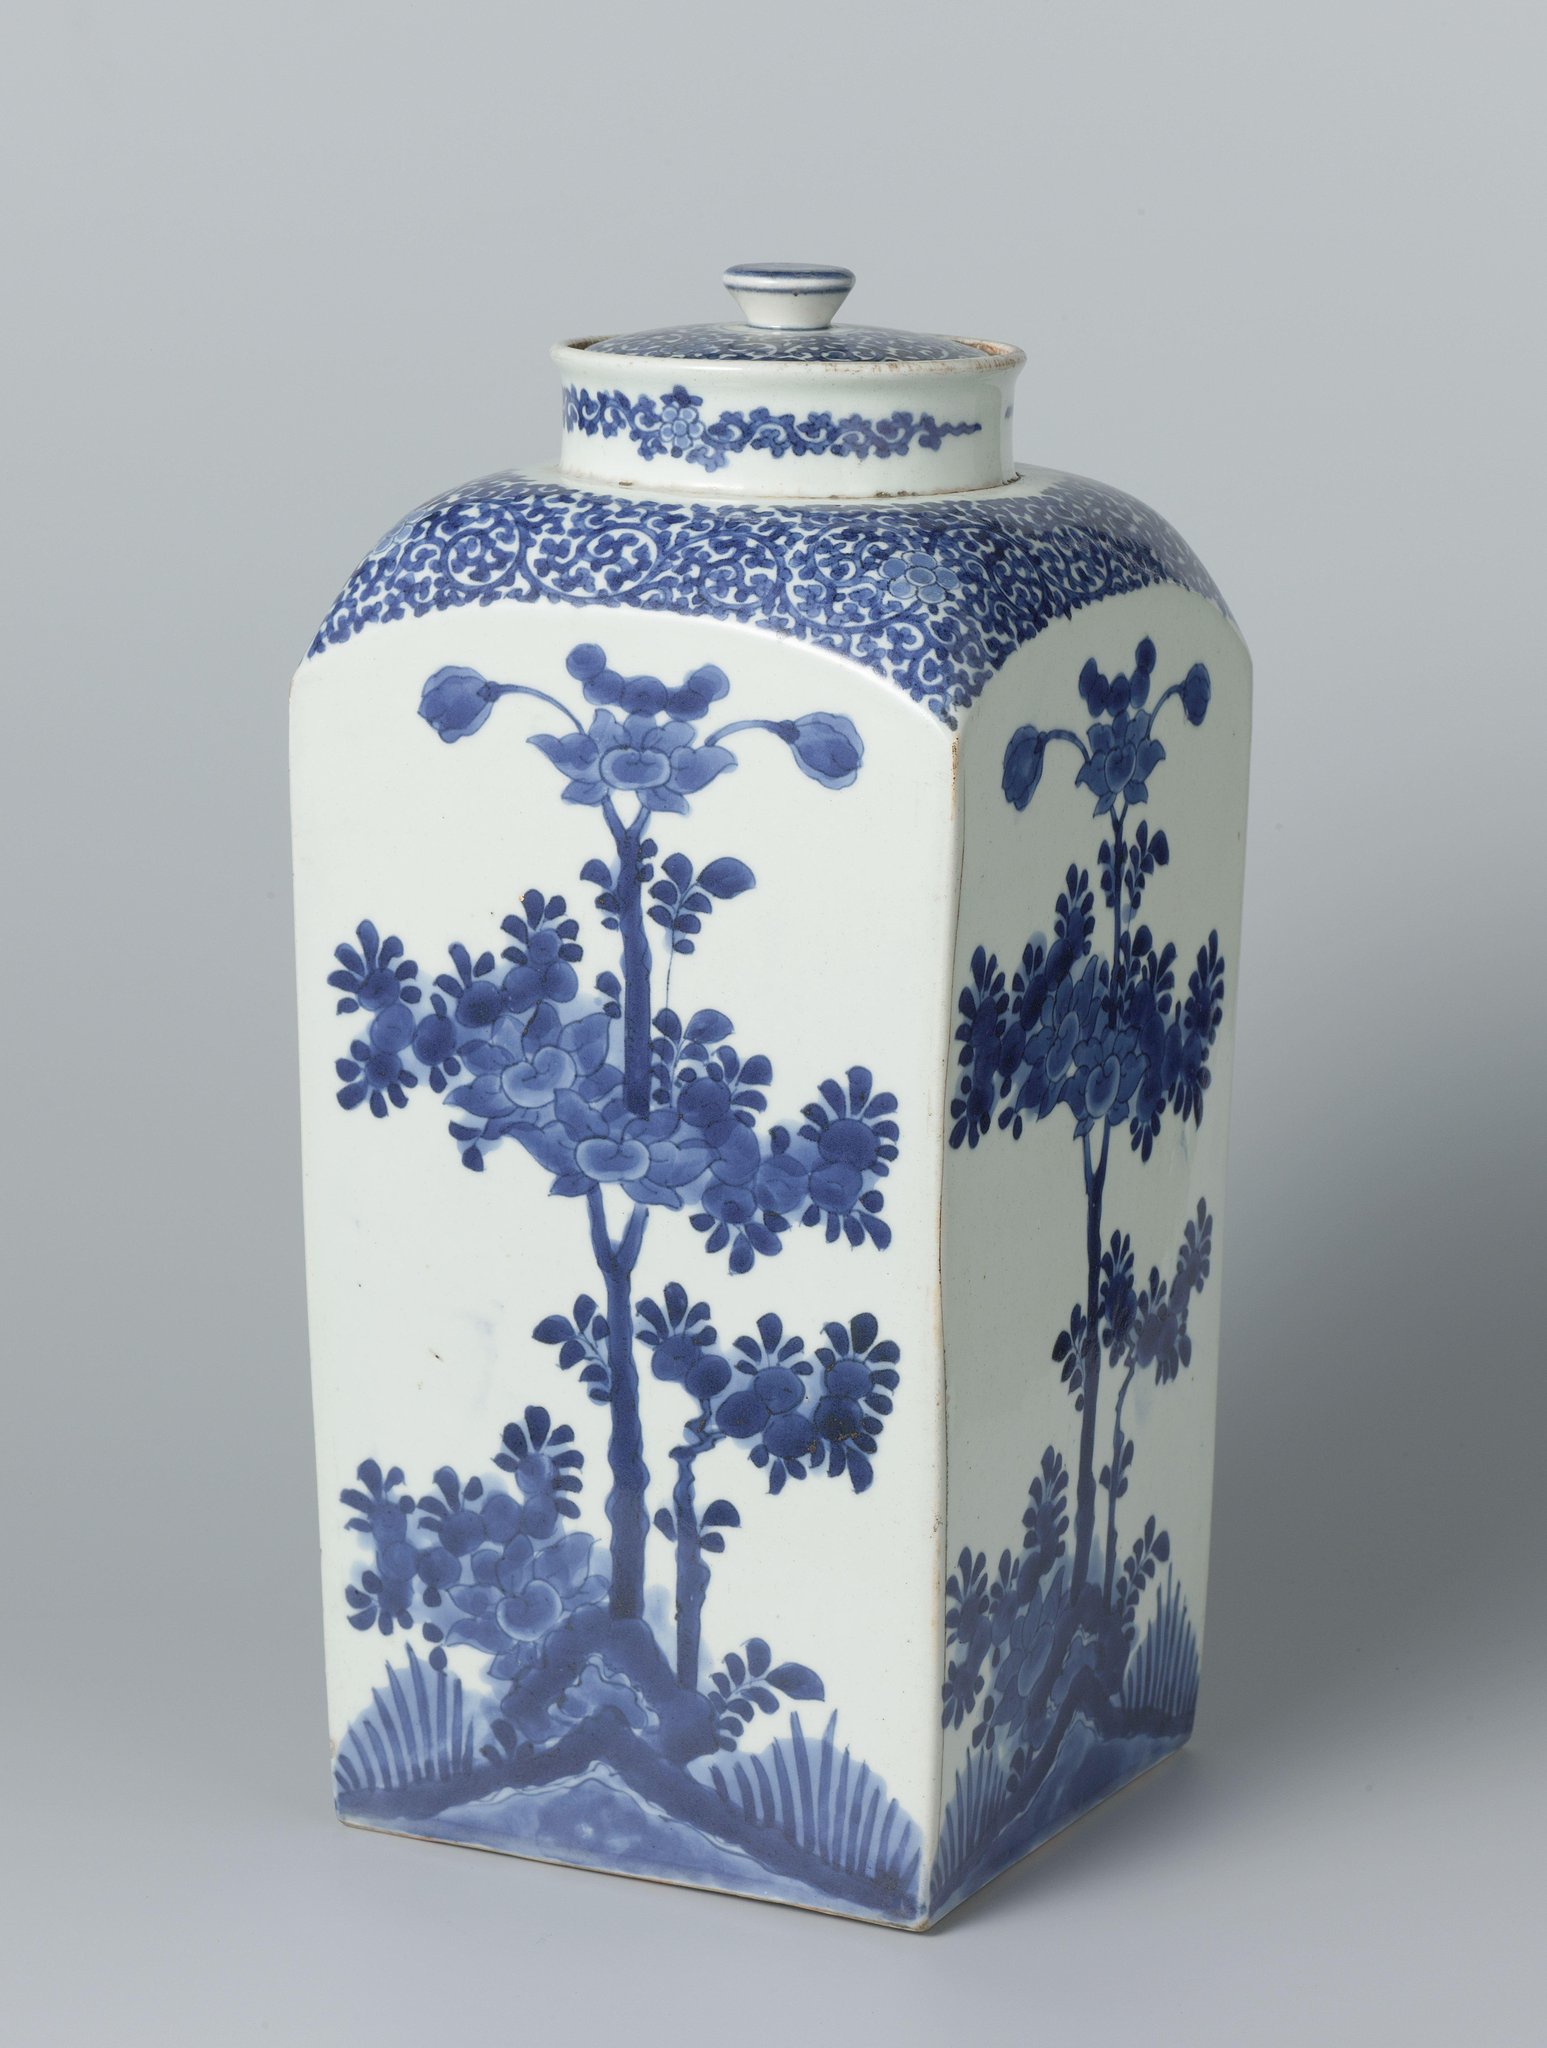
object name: bottle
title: Square bottle with scrolls and flowering trees near rocks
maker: Anonymous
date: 1680-1710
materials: cobalt, glaze, paint, porcelain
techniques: firing, forming, turning, vitrification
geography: arita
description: Vierkante fles van porselein, beschilderd in onderglazuur blauw. Op de vier wanden telkens een bloeiende boom bij een rots. Op de ronde schouder 'karakusa-ranken'. De hals met tweemaal een bloemrank. De rand van de fles is gerestaureerd. Arita, Kakiemon in blauw-wit.